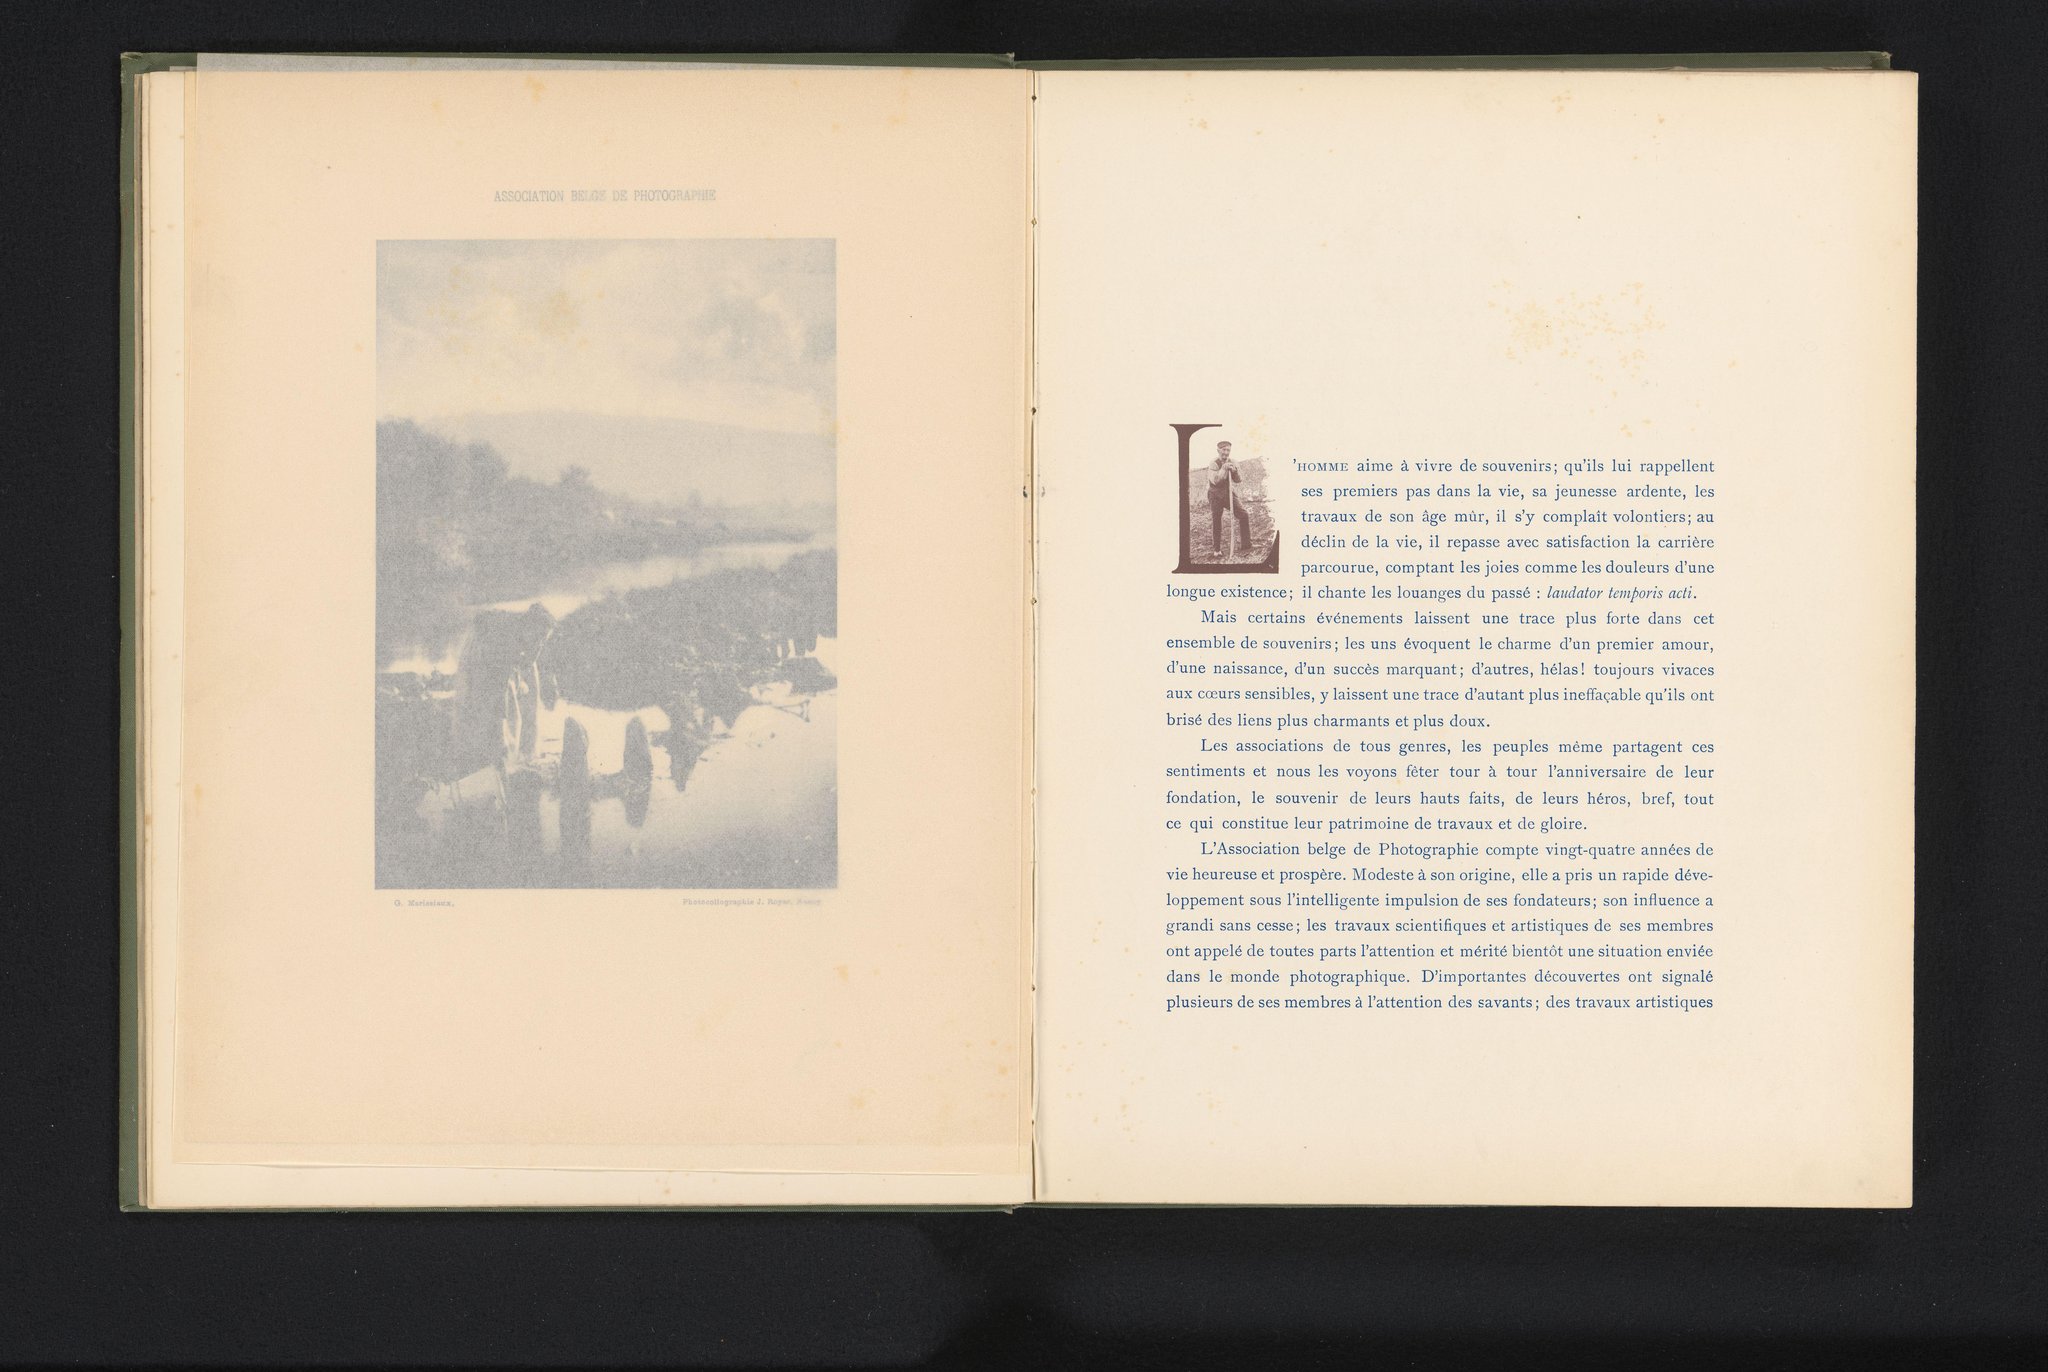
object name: page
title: Boer op het land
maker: Anonymous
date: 1893-1898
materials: paper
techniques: autotype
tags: farmers